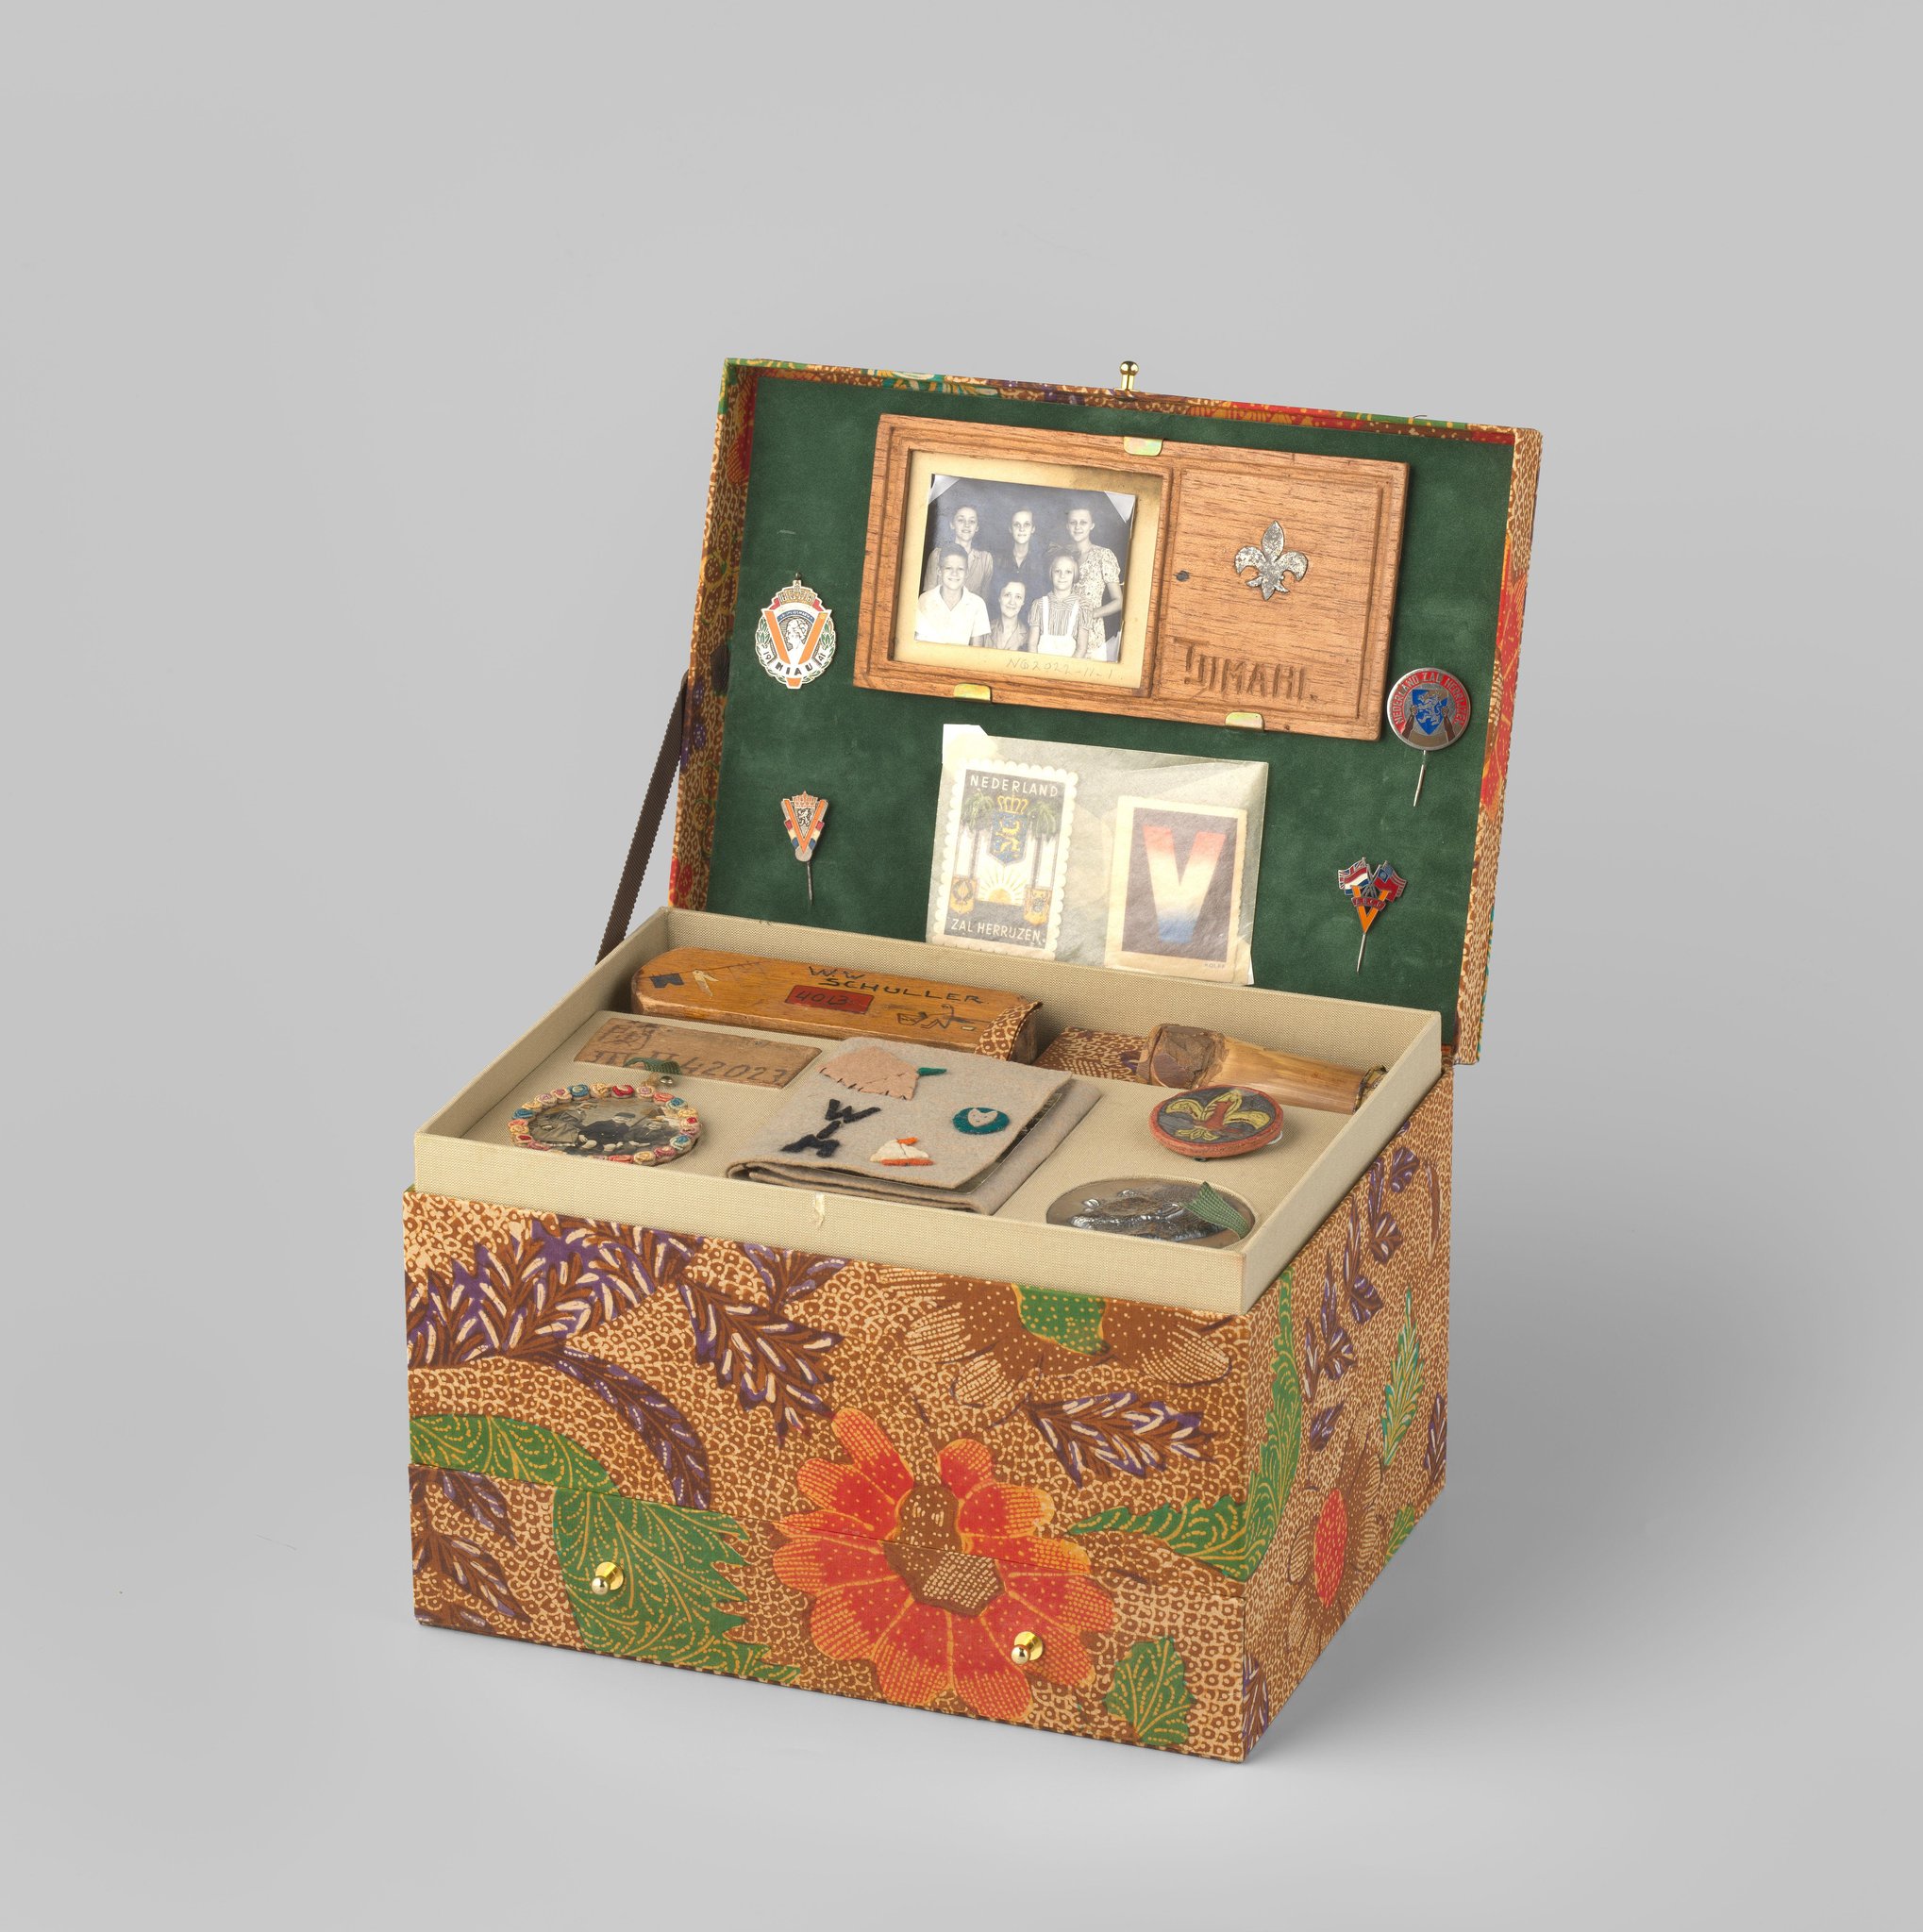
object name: box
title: Grogoldoos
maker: willem woutherus schüller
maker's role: samensteller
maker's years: 1932-2022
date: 1930-1994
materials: cardboard, felt, linen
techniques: batik, various techniques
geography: netherlands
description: Willem Wouterus Schüller stelde in het voorjaar van 1994, tijdens zijn opname en daaropvolgende dagbehandeling in de werkplaats van de ergo-therapie (afdeling psychiatrie in het St Lukasziekenhuis, Amsterdam) de inhoud van deze doos samen. Schüllers ontwerp werd vervolgens uitgevoerd door Atelier Ada Teitler-Terweij in Amsterdam. De zogenoemde Grogoldoos (Grogol is de naam van het burgerkamp waar Schüller geïnterneerd was tijdens de Japanse bezetting van Indonesië) is een product van therapie, een poging van Schüller om zijn traumatische ervaringen tijdens en herinneringen aan de oorlog in Indië/Indonesië een plaats te geven. Heel concreet gebeurde dat door 90 voorwerpen/documenten in verschillende plateau’s, kleinere doosjes en enveloppen onder te brengen. Die voorwerpen/documenten zijn afkomstig uit het kamp, maar zijn ook van eerdere en latere datum, waaronder de eerste maanden na Japanse capitulatie. Op het papieren vlakje onder de leporello van stof in balpoint: "Schat! De doos vooral dichtlaten als het je enerveert. Liefs xxx An" De Grogoldoos is getoond op de tentoonstelling Beelden van de Japanse bezetting van Indonesië in het Rijksmuseum, 1999.